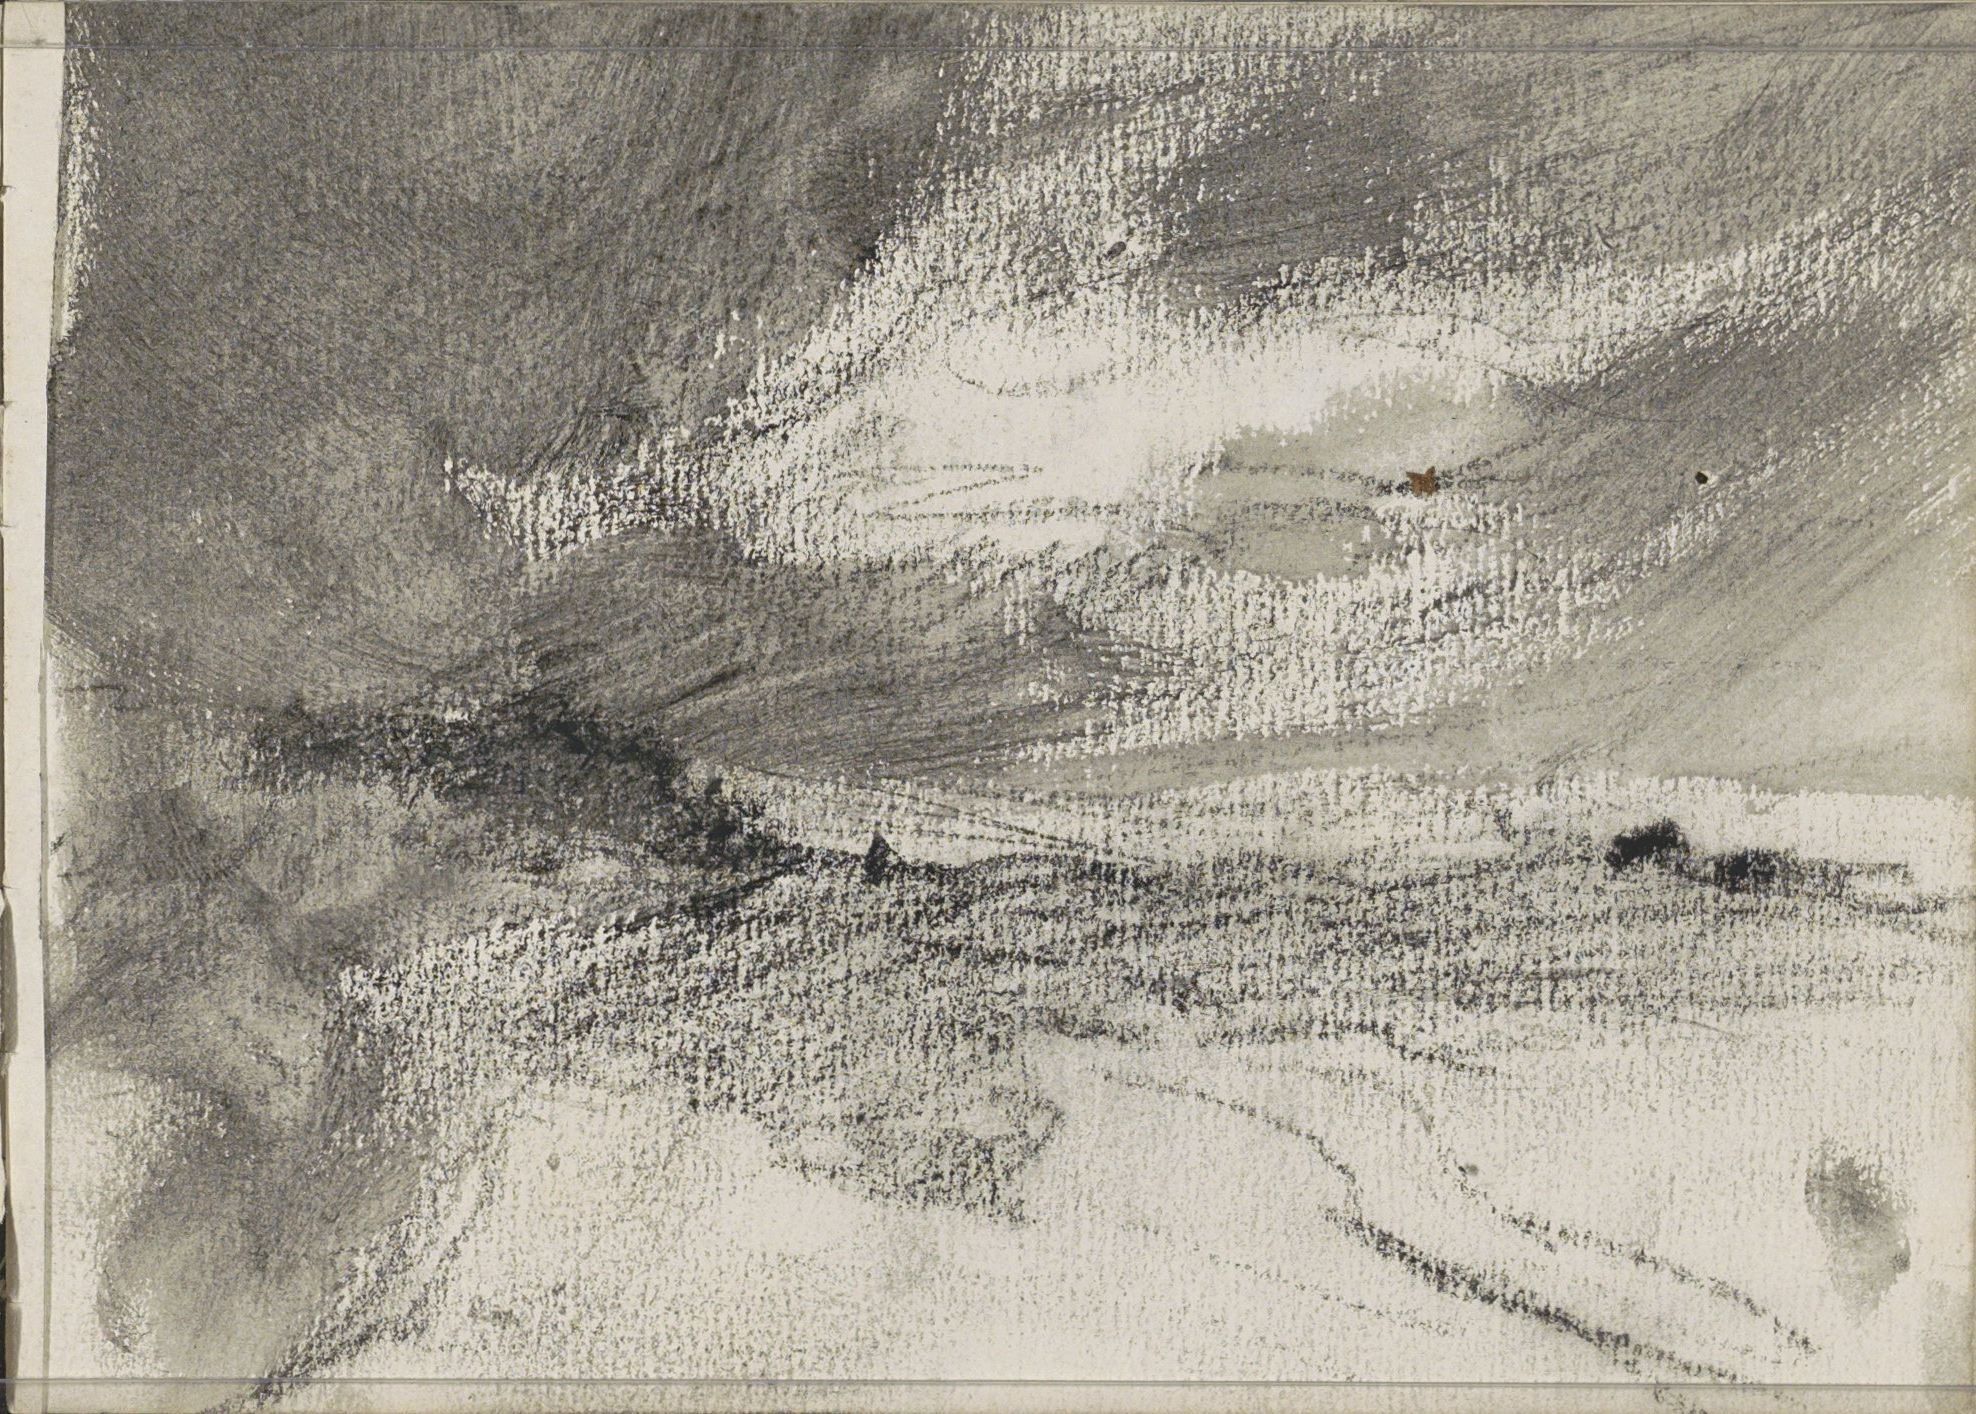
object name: sketchbook leaf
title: Heuvellandschap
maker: anton mauve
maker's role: draughtsman, painter, print maker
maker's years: 1838-1888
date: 1848-1888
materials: chalk, paper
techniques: brush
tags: low hill country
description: Blad 23 recto uit een schetsboek met 31 bladen.